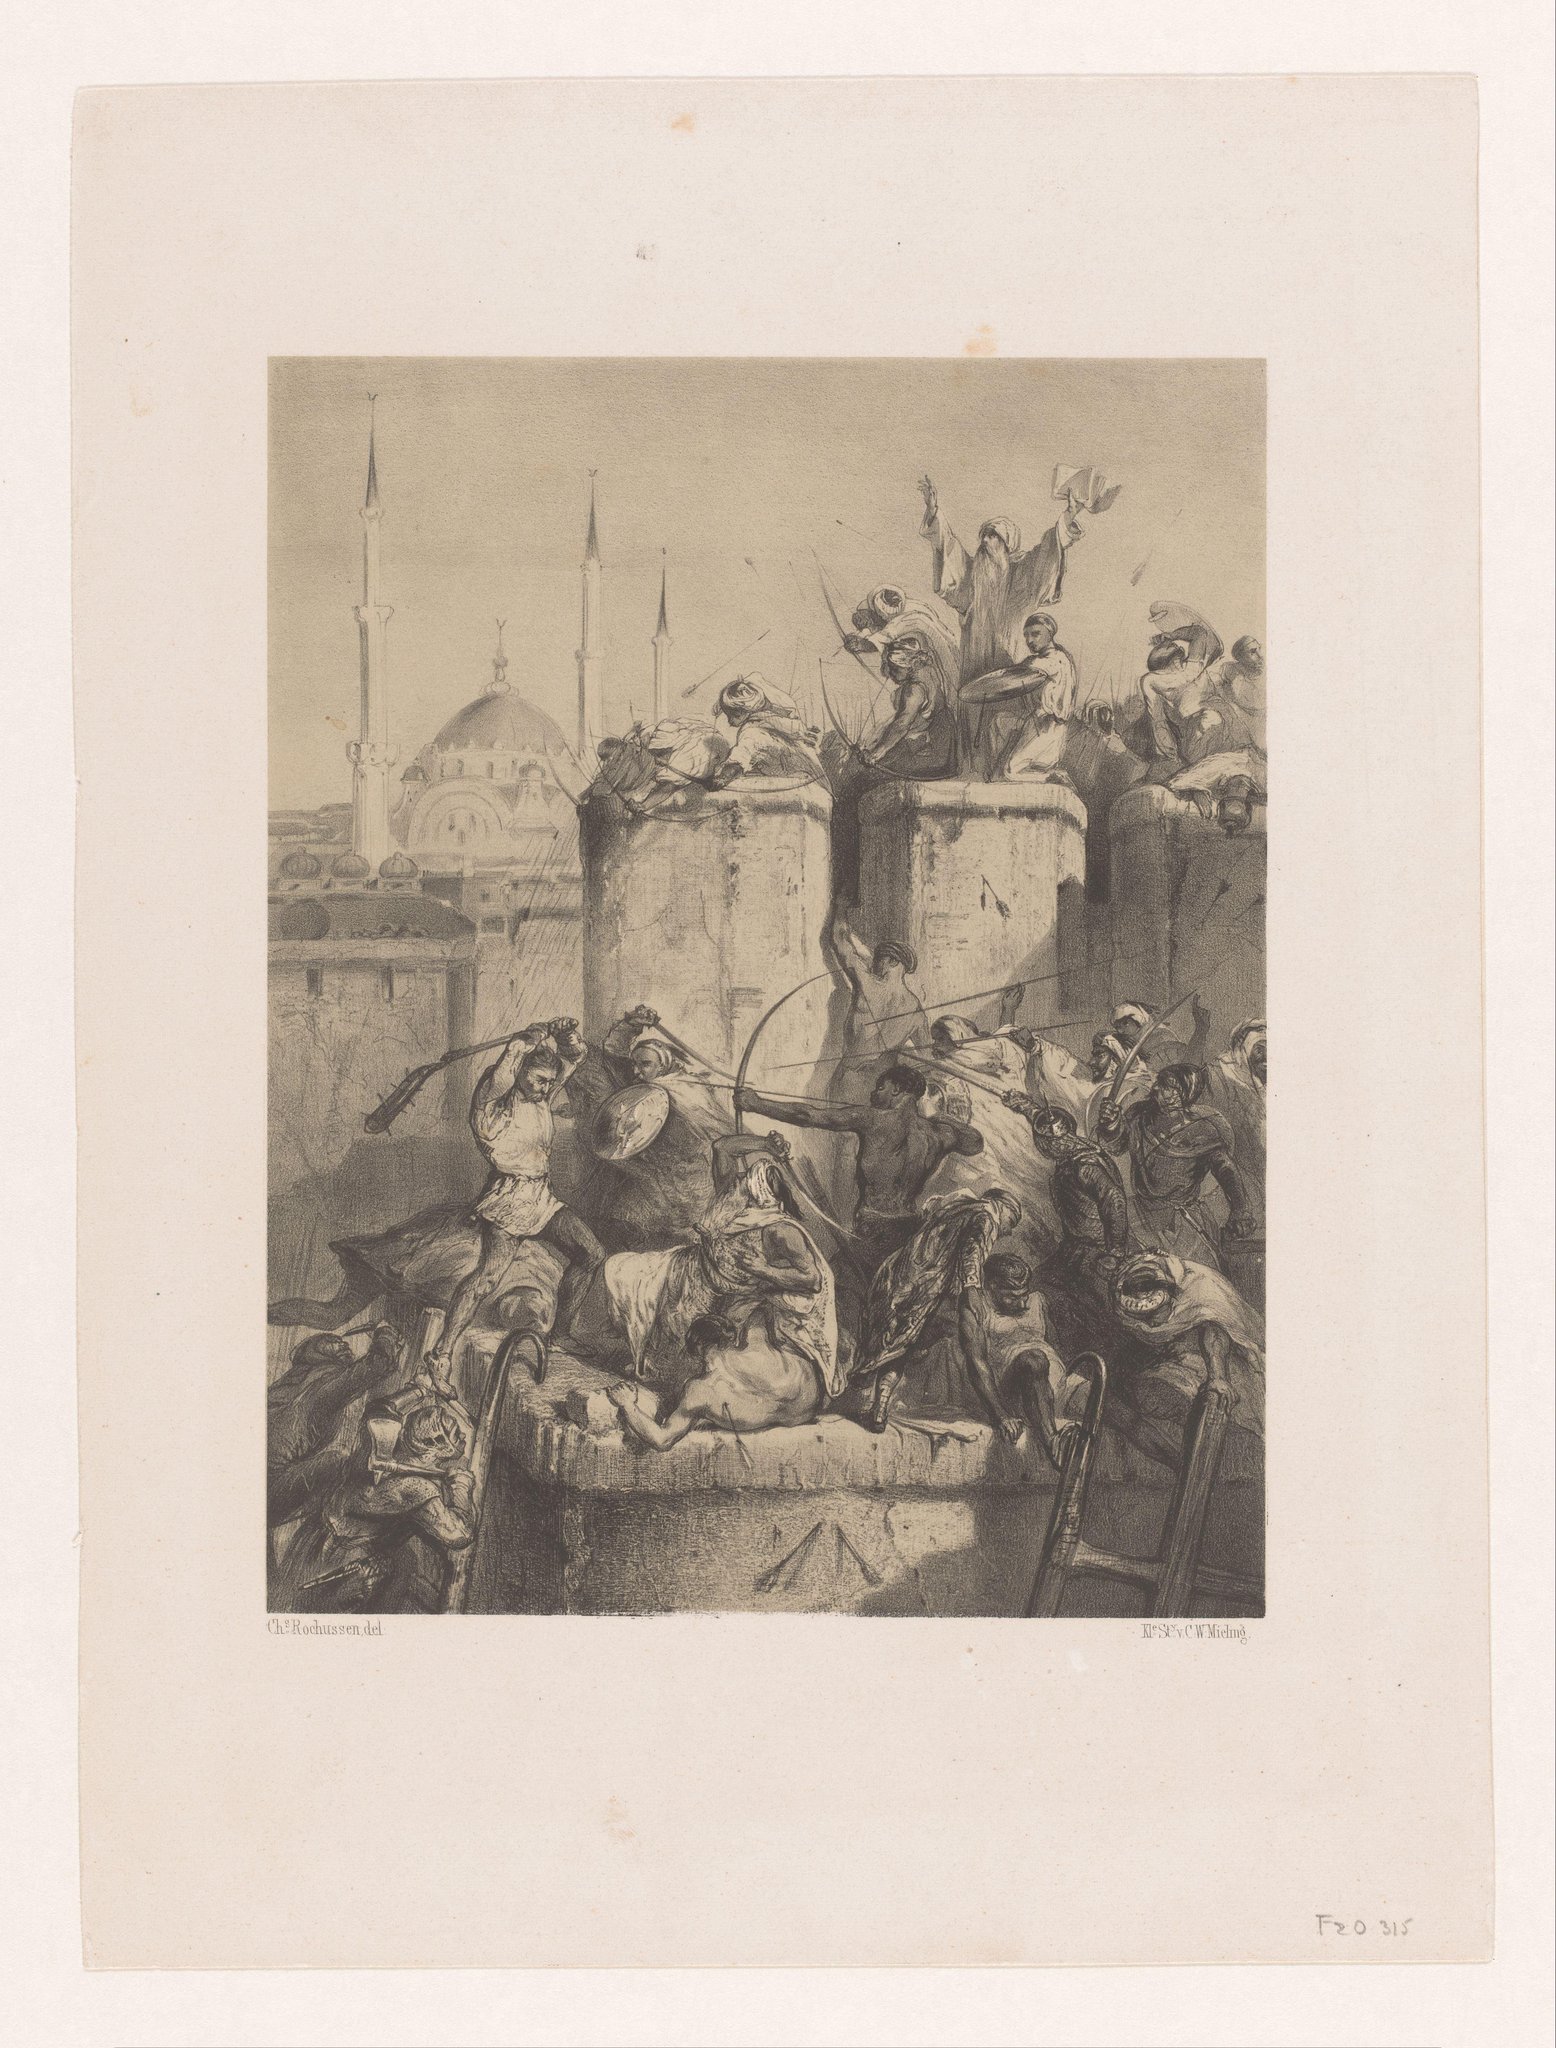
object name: book illustration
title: Bestorming van een Turks fort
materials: paper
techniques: tone lithography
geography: the hague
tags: breaking into city or fortress ~ siege, asiatic races and peoples: turks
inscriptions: collector's mark: Lugt 2228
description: Ridders bestormen een fort verdedigd door Turken met pijl en boog. In de achtergrond een moskee.